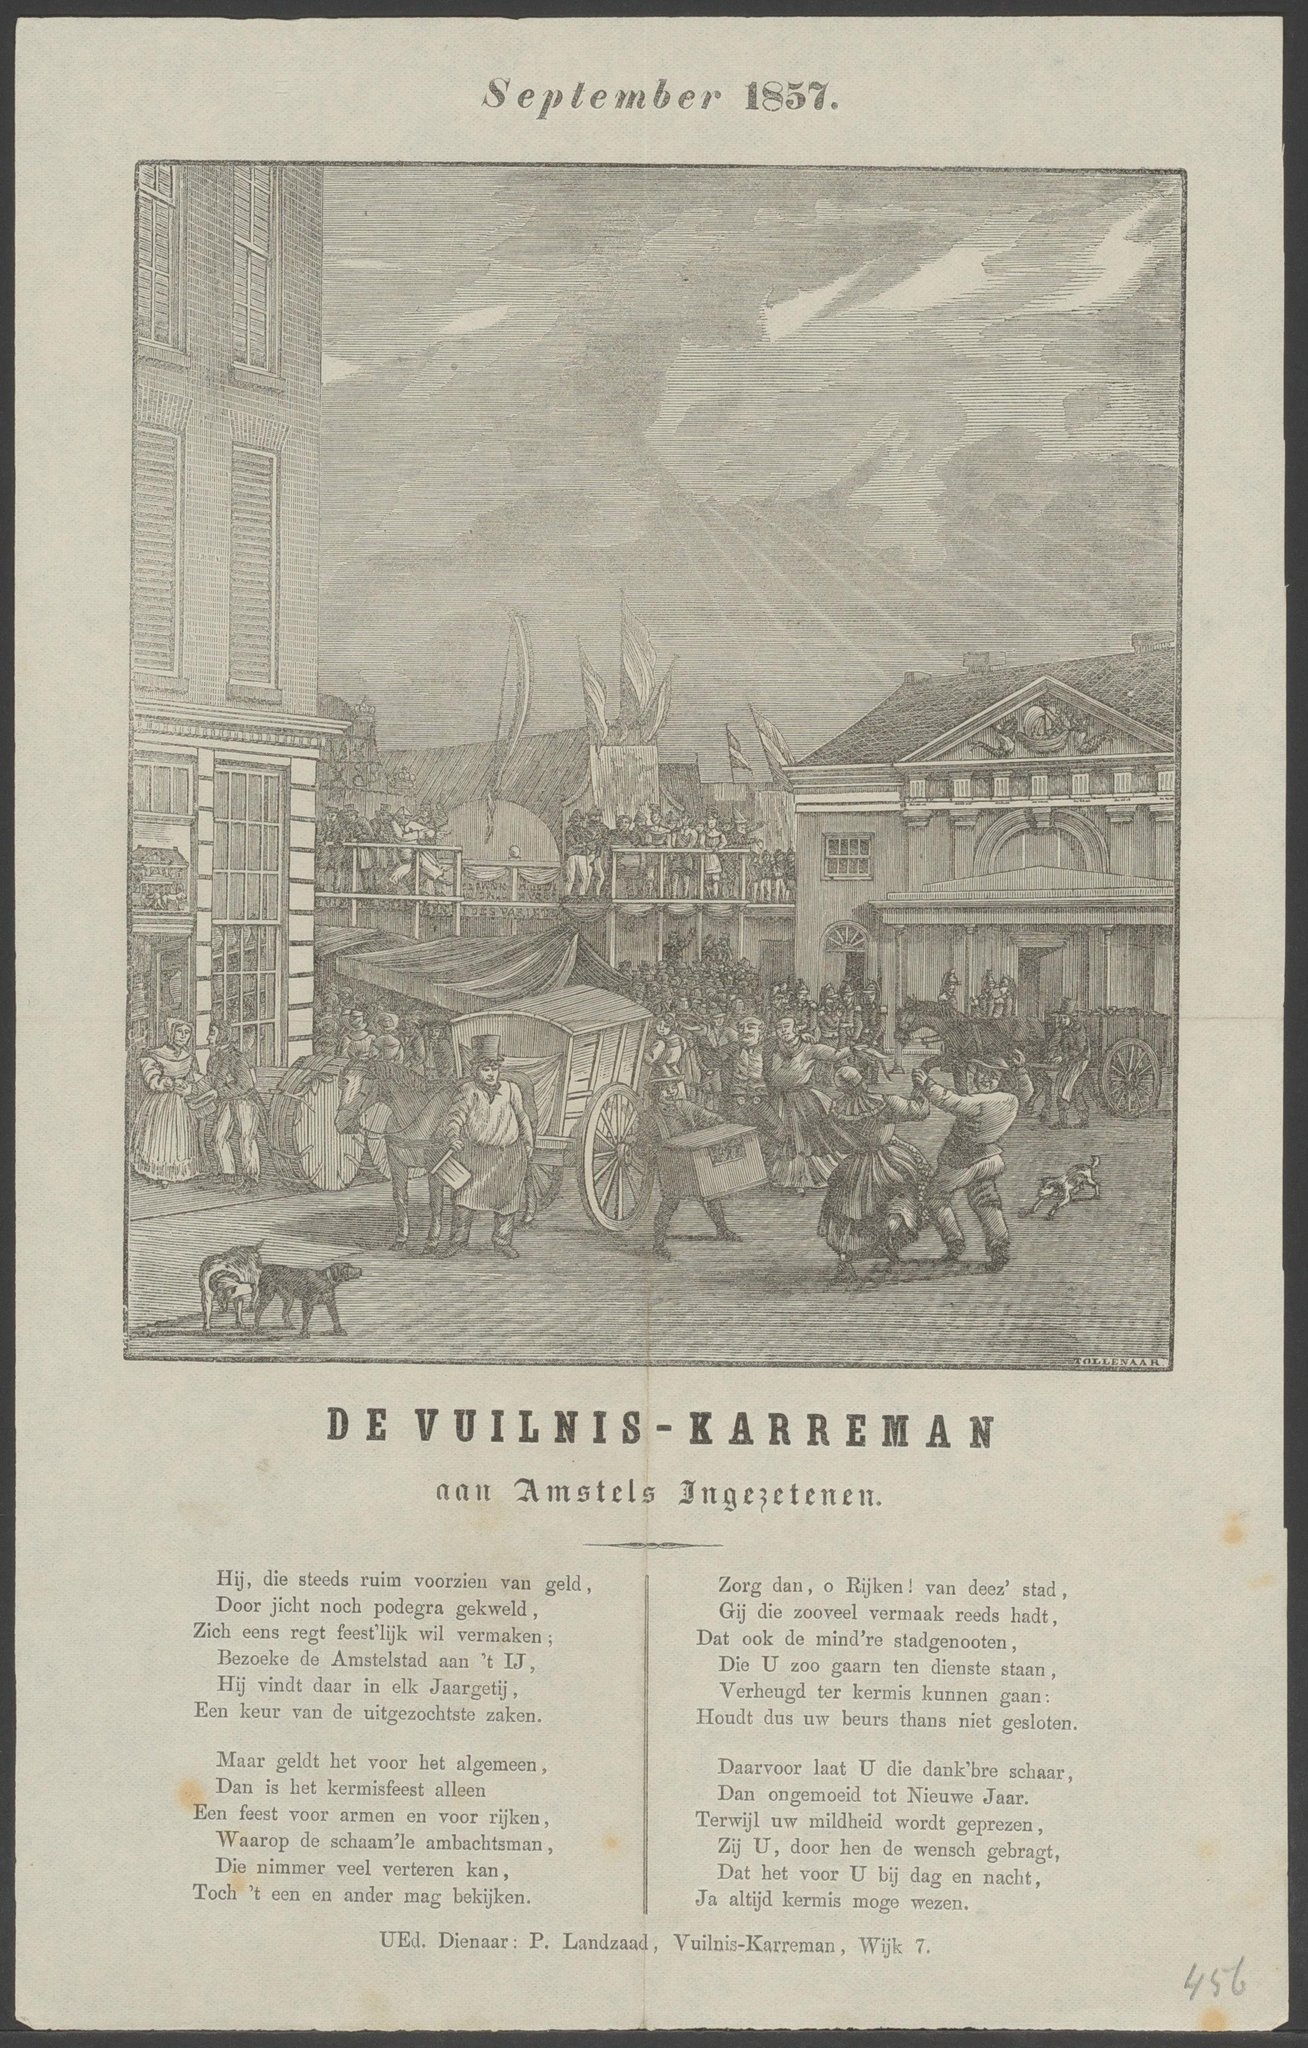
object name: print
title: Kermisprent van de vuilnismannen van Amsterdam voor het jaar 1857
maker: dirk wijbrand tollenaar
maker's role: print maker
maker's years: 1808-1858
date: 1857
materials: paper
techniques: letterpress printing, engraving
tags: street, garbage collection, amsterdam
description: Kermisprent van de Amsterdamse vuilnismannen voor het jaar 1857. Gezicht op de kermis op de Botermarkt met de oude Waag. Op de markt twee vuilniskarren. Met gedicht in twee kolommen. Van de vuilniskarman in de wijk no. 7: P. Landzaad. Onderwerpsrubrieken binnen de Atlas Zeden en Gewoonten: Zeden en gewoonten in engeren zin, Volksleven, Volksbladen, Nieuwjaars- en Kerstwenschen, Amsterdam.